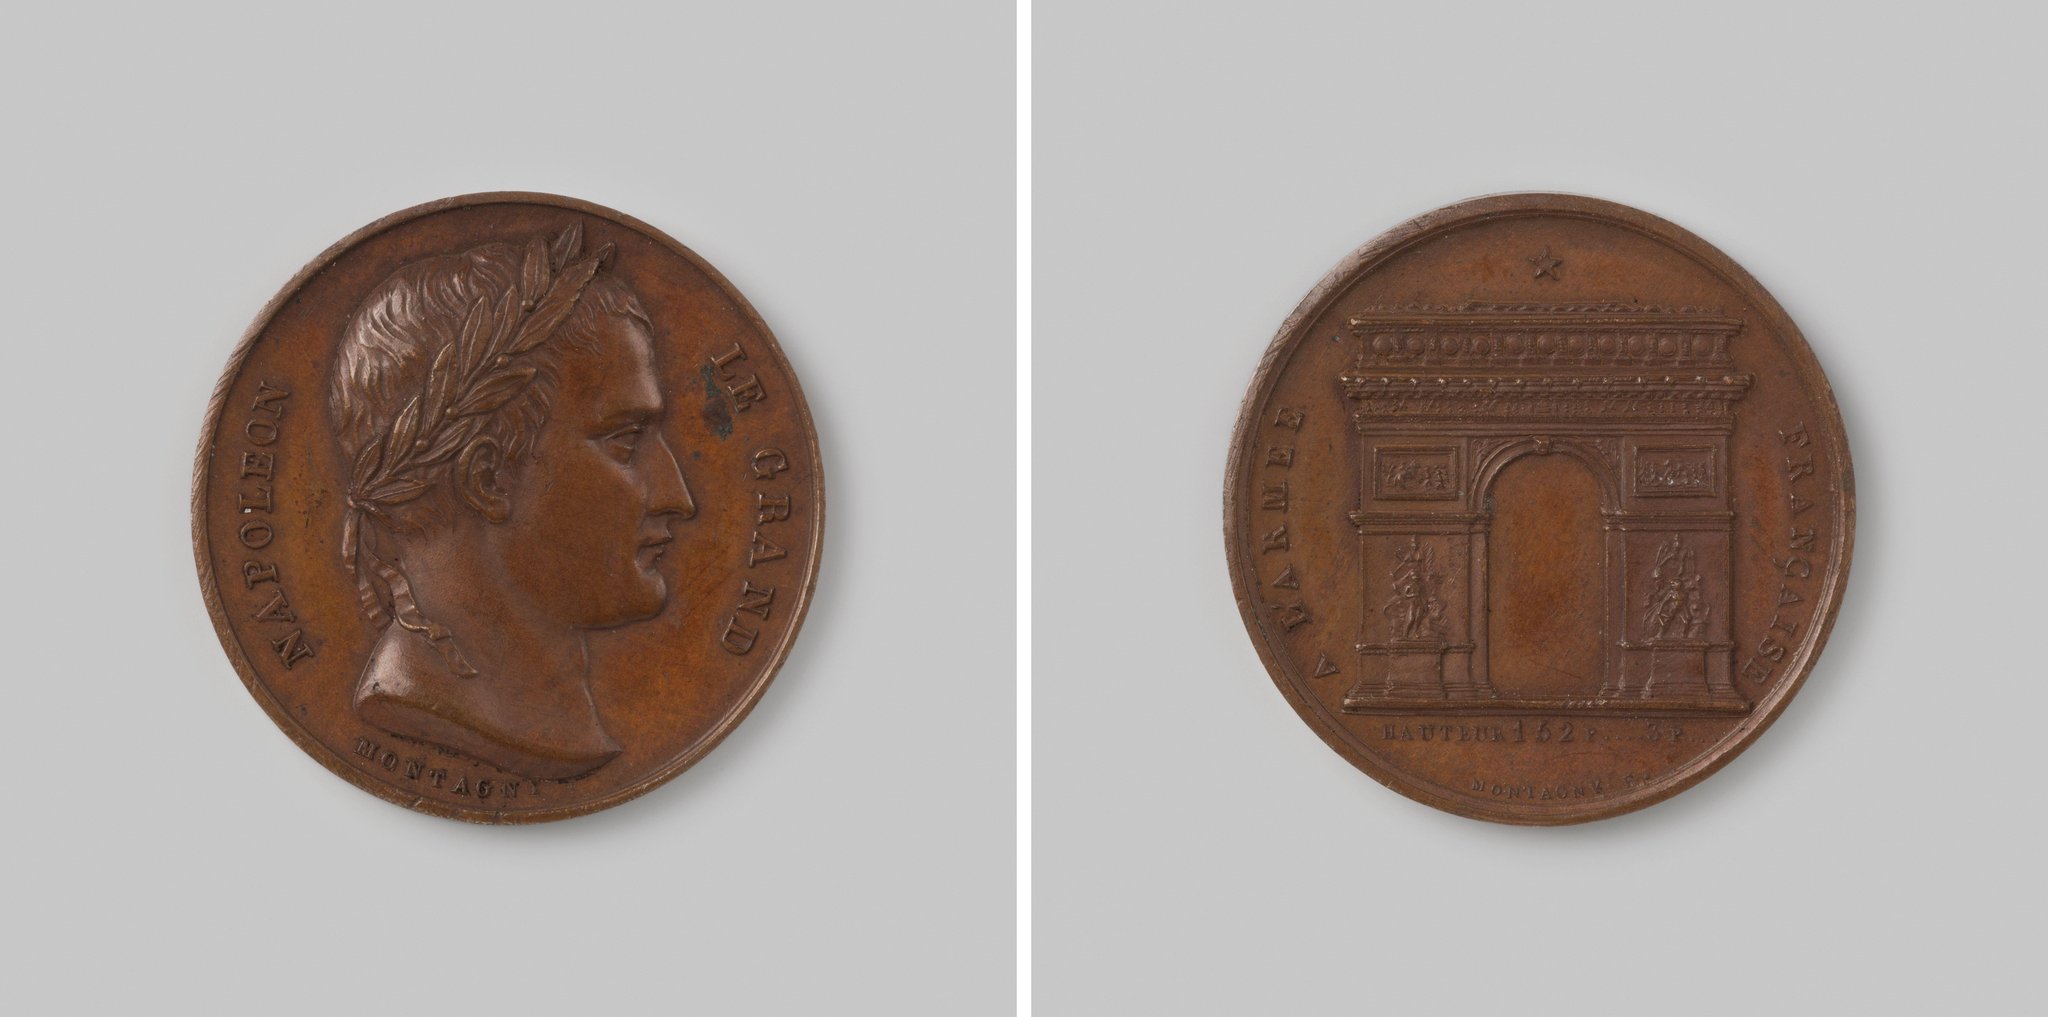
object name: history medal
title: Inwijding van de Arc de Triomphe te Parijs 1836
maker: montagny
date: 1836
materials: copper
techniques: striking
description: Bronzen penning, op de voorzijde het portret van Napoleon naar rechts met omschrift, op de keerzijde de Arc de Triomphe waarboven een ster, met omschrift en afsnedetekst.